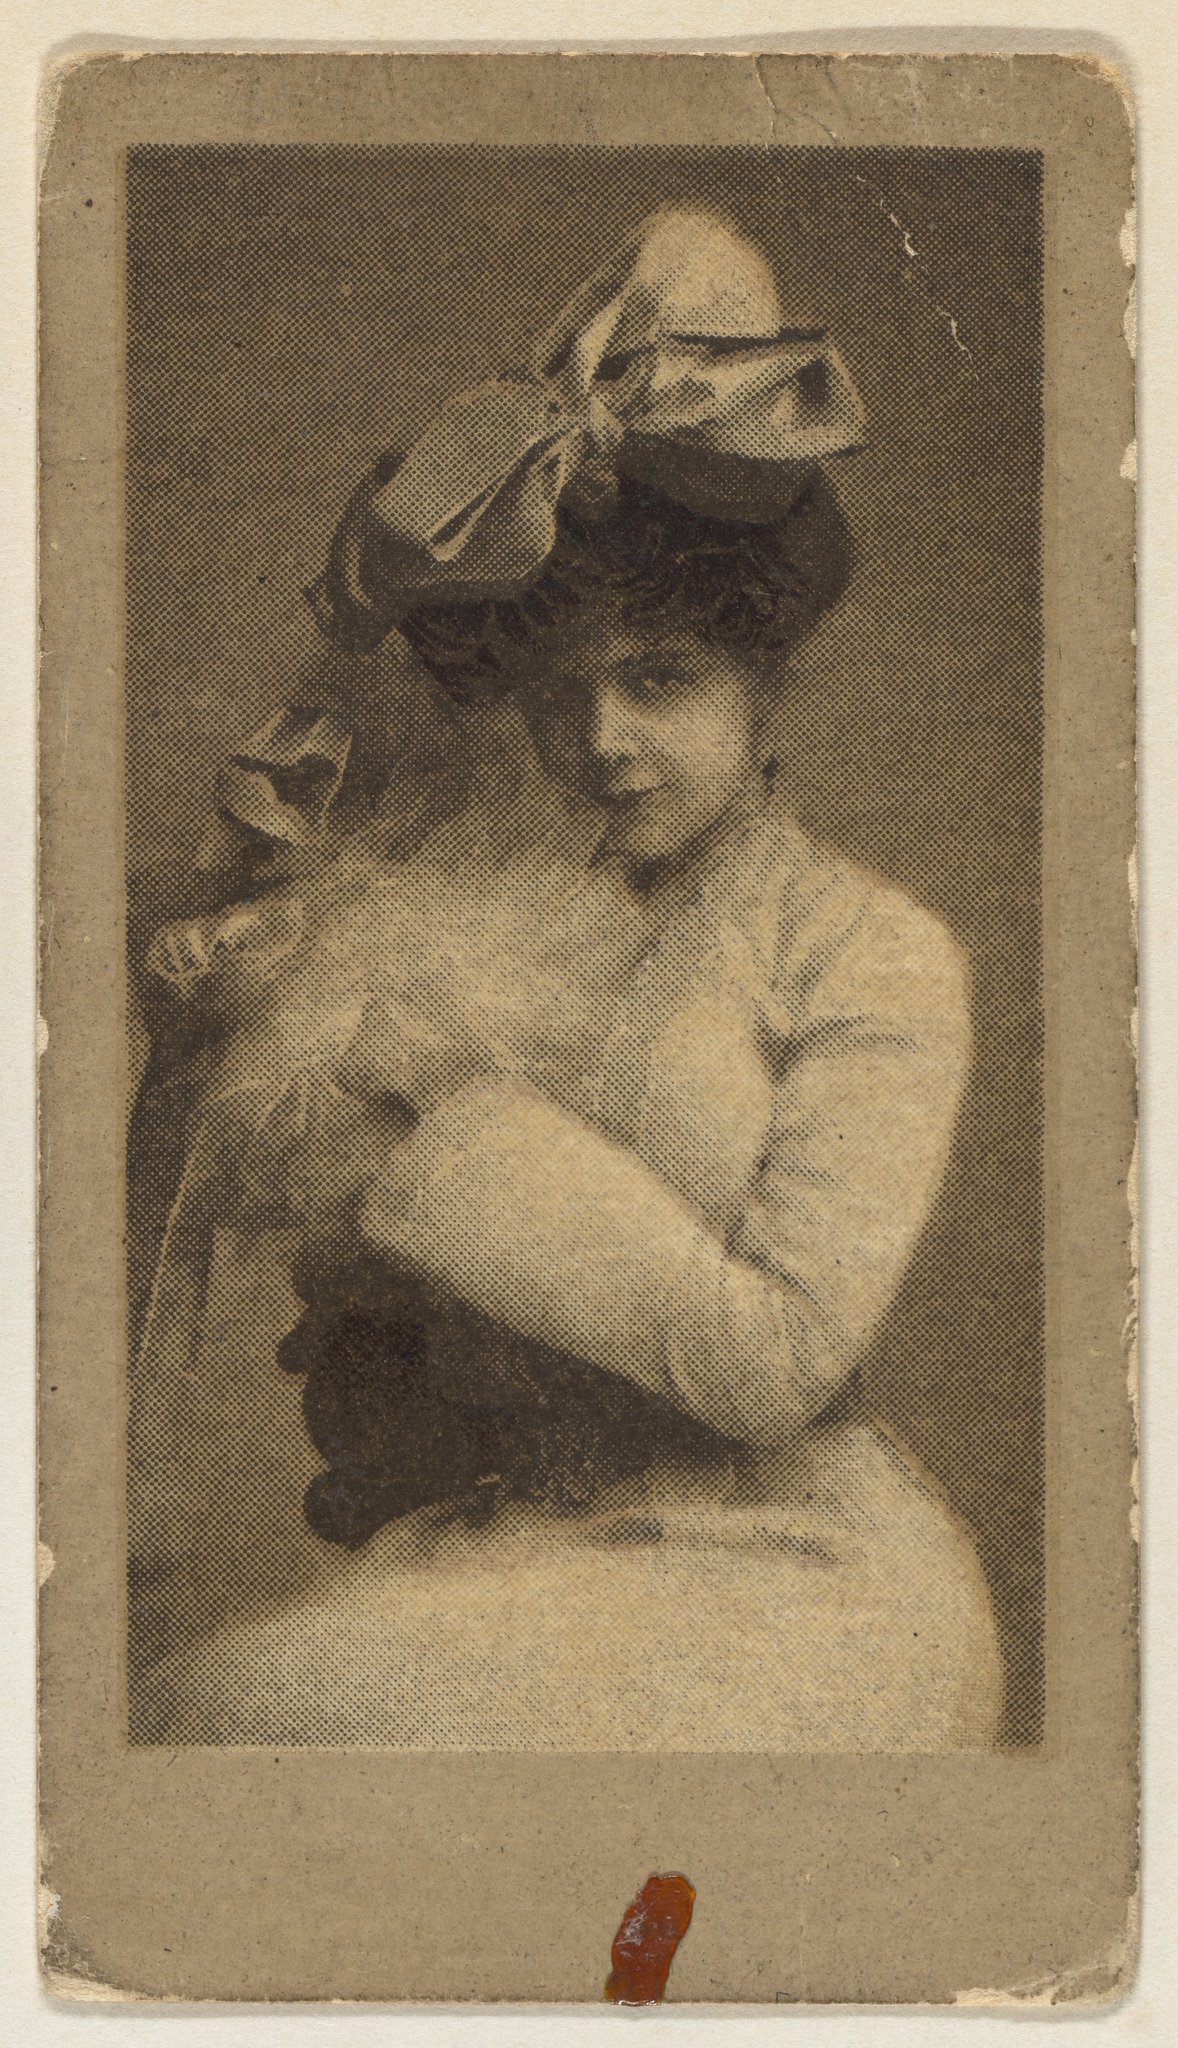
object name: print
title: Portrait of a woman wearing a large bow in her hair, from the "Girls" series (T66), issued with Hunter Dog Cigarros by S. Monday & Sons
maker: s. monday & sons, brooklyn, new york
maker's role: publisher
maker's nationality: american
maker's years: 1850-1950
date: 1900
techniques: photolithograph